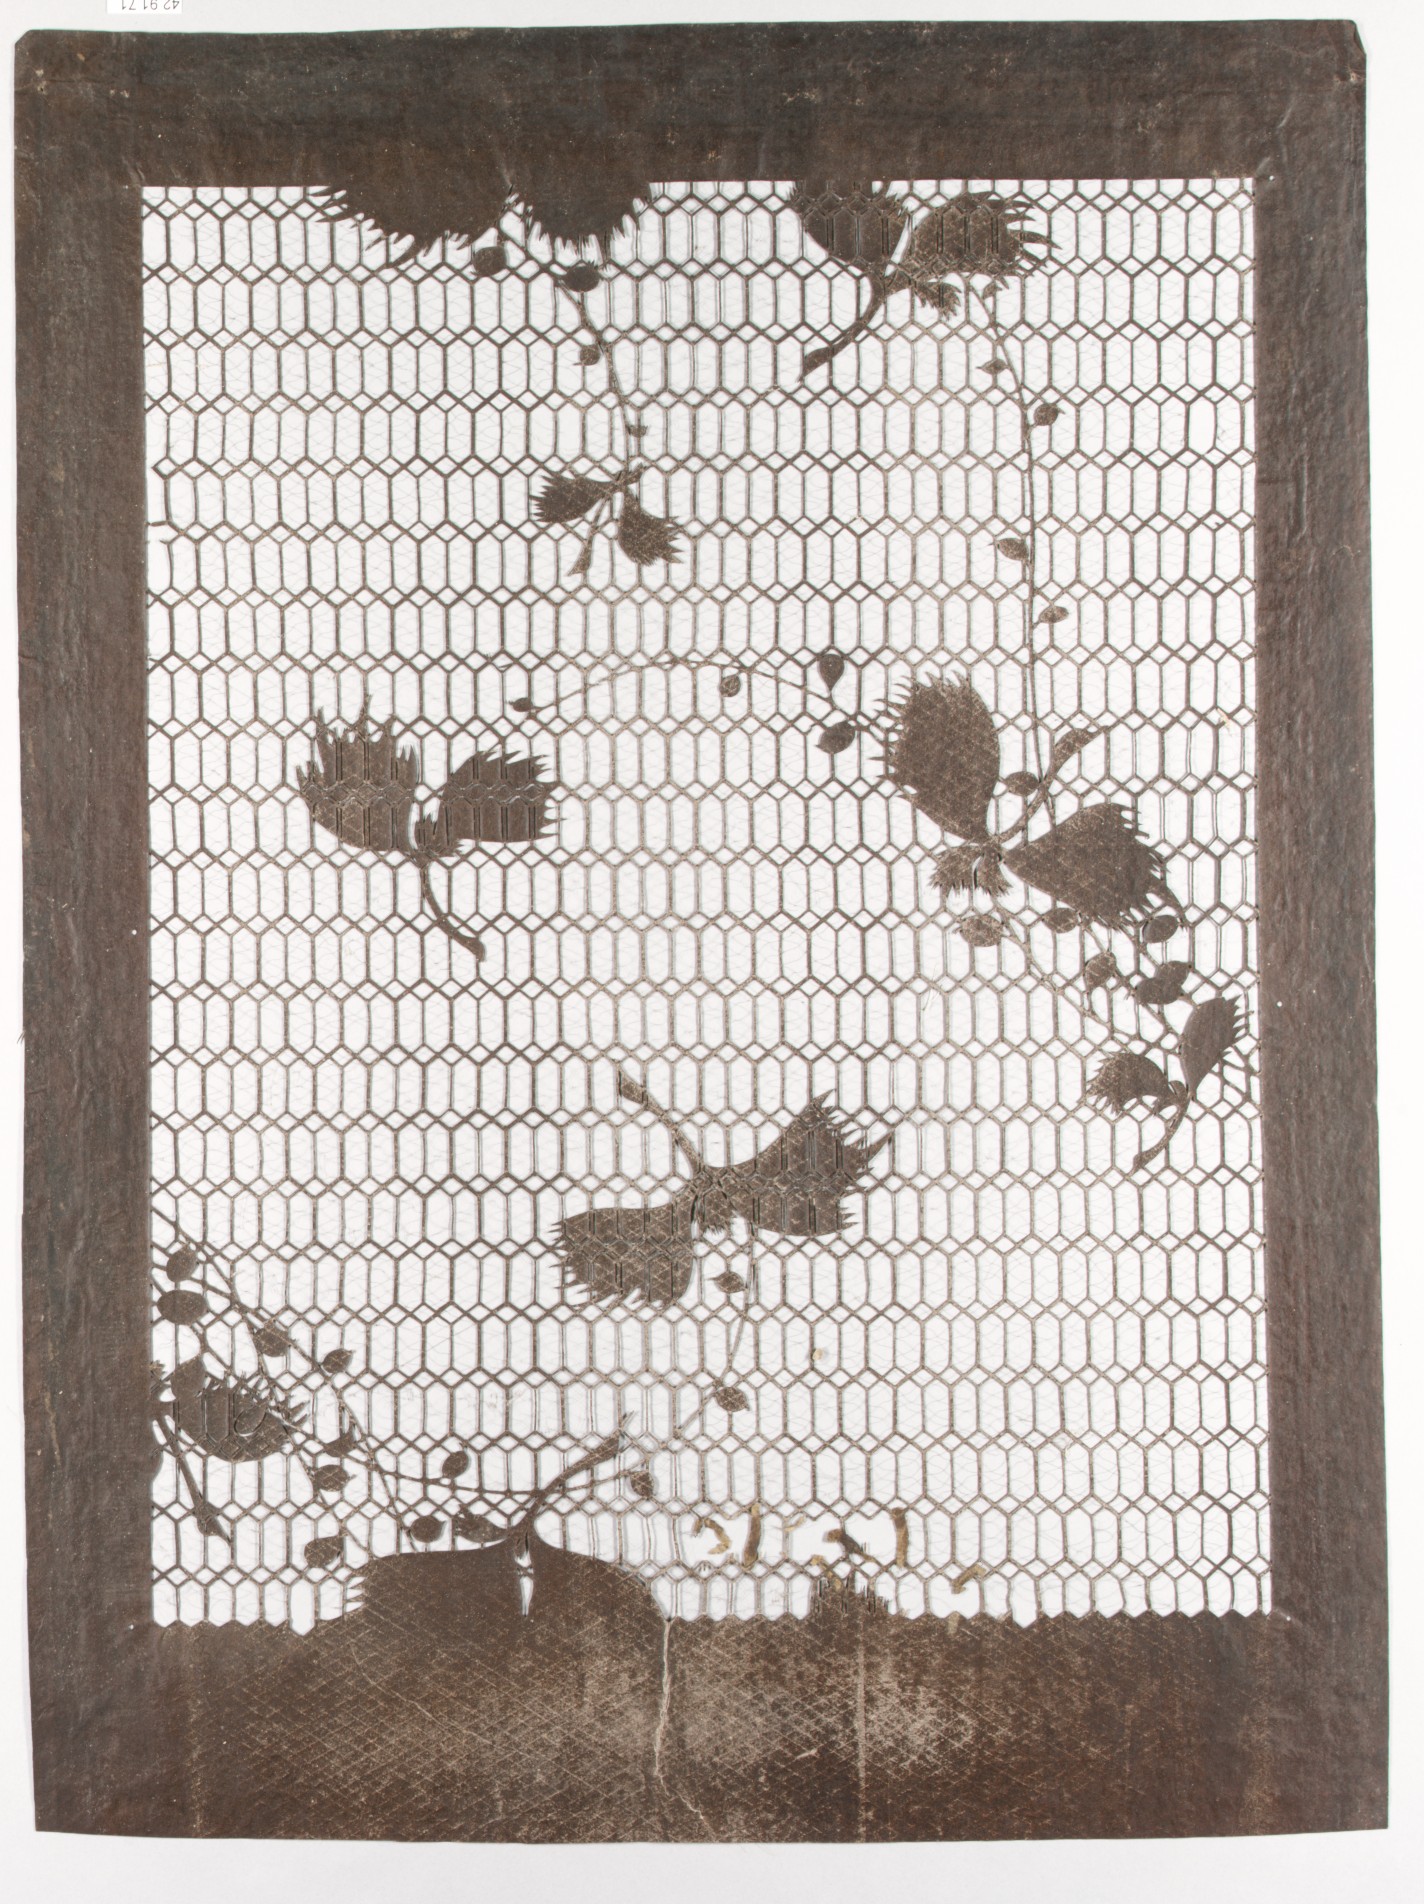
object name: stencil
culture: japanese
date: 1801-1900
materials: paper, silk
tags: leaves